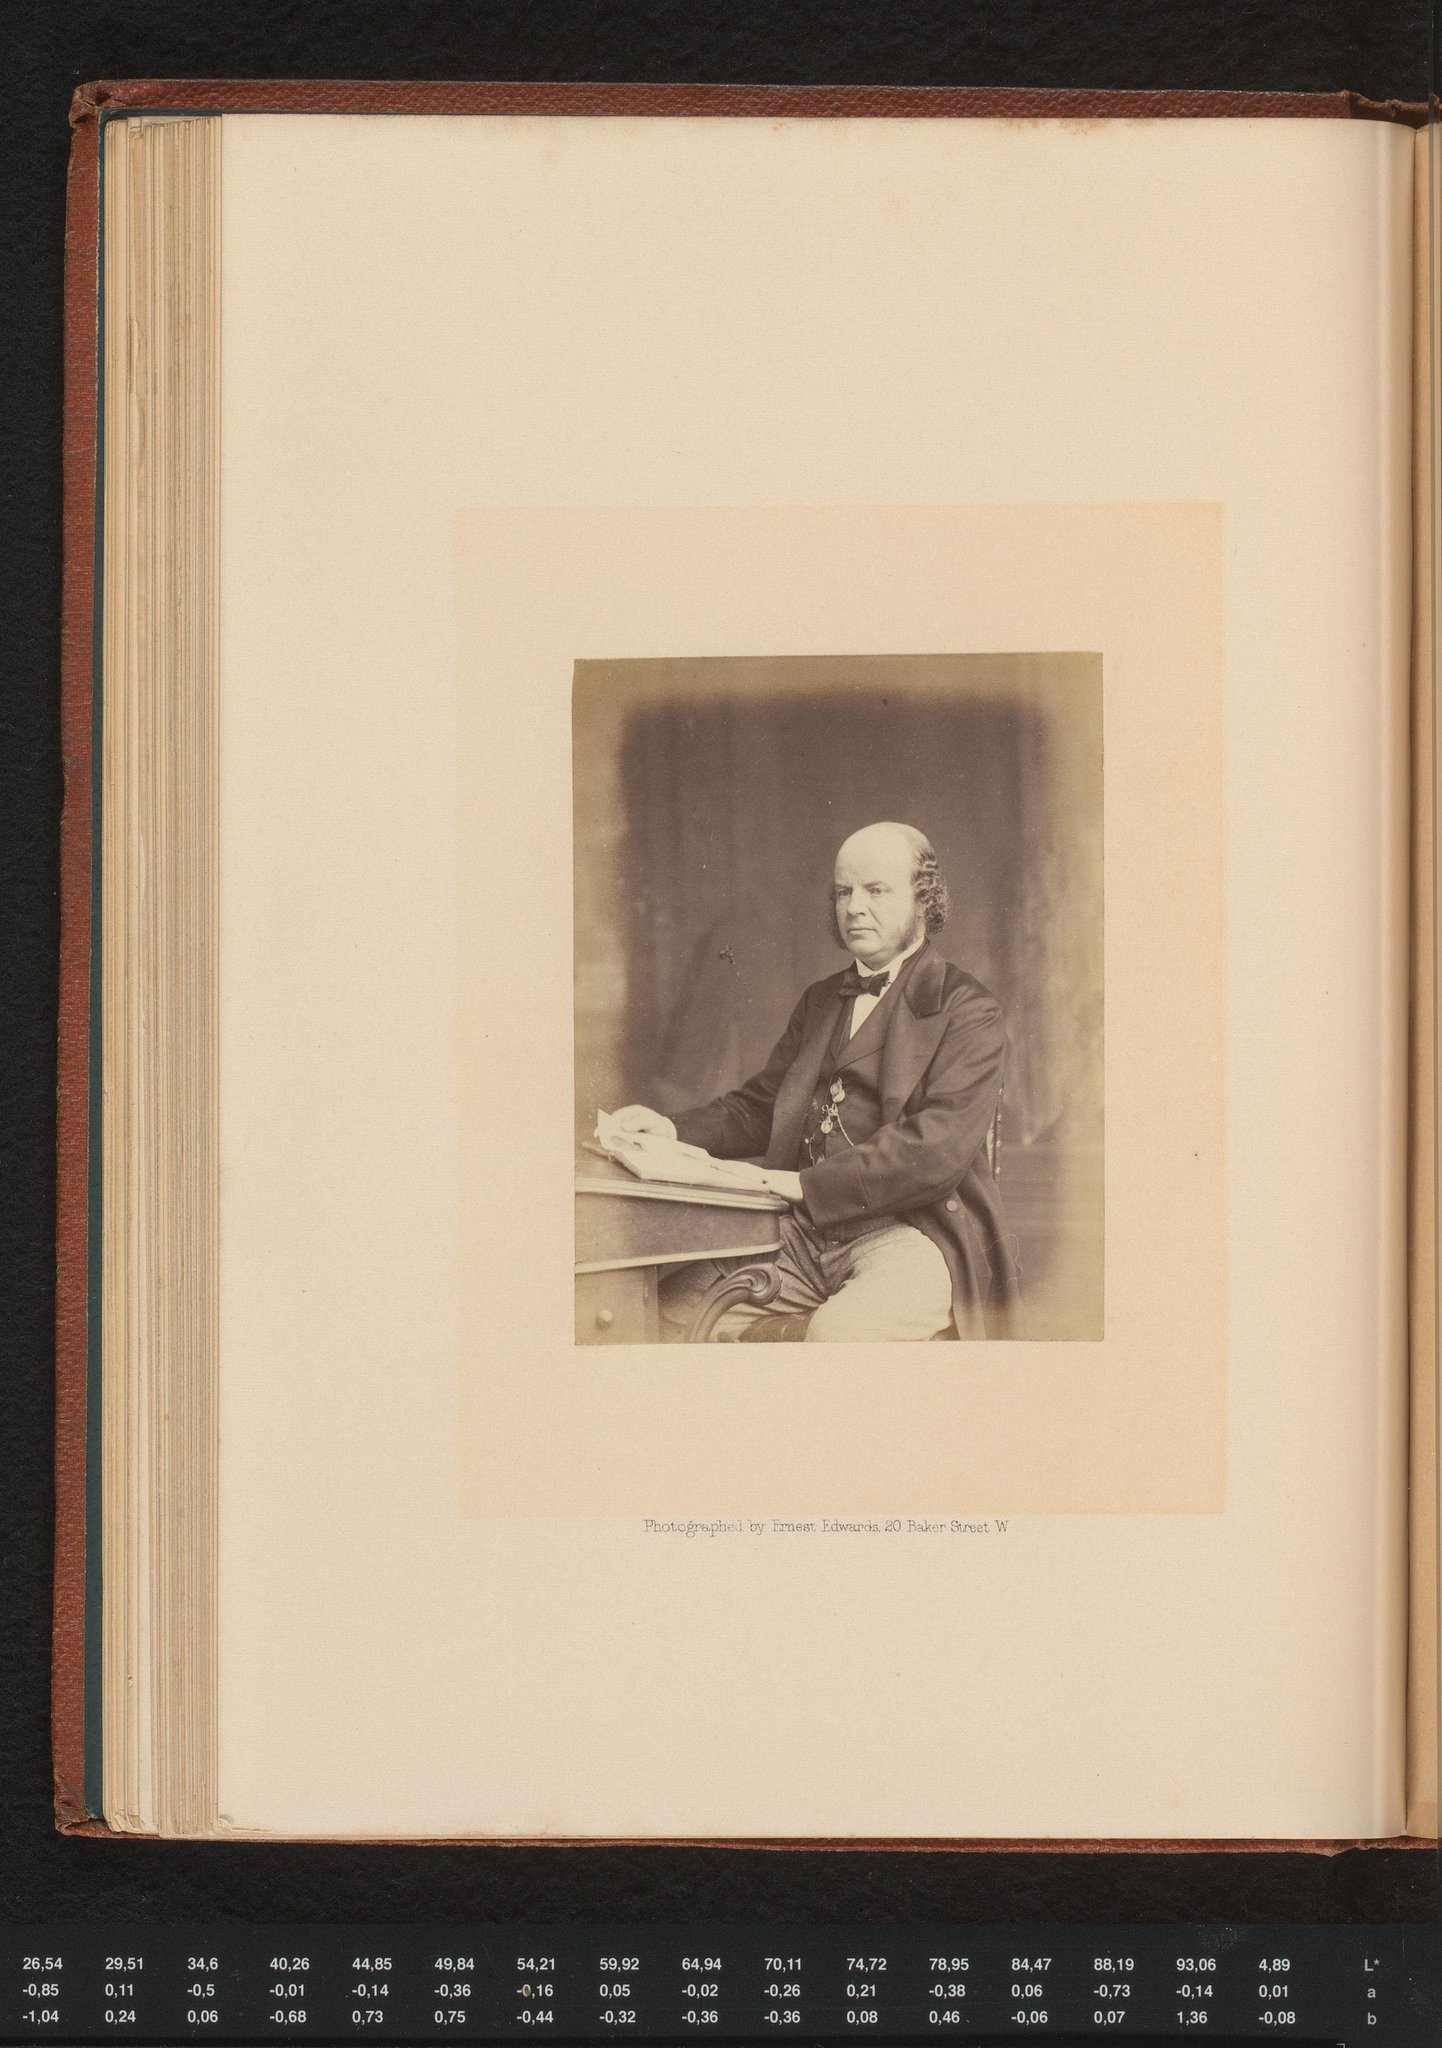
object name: page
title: Portret van de predikant Bernard Bolingbroke Woodward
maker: ernest edwards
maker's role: fotograaf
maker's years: 1837-1903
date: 1862-1867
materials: paper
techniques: albumen print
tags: adult man, historical persons, functionaries and dignitaries ~ protestant churches